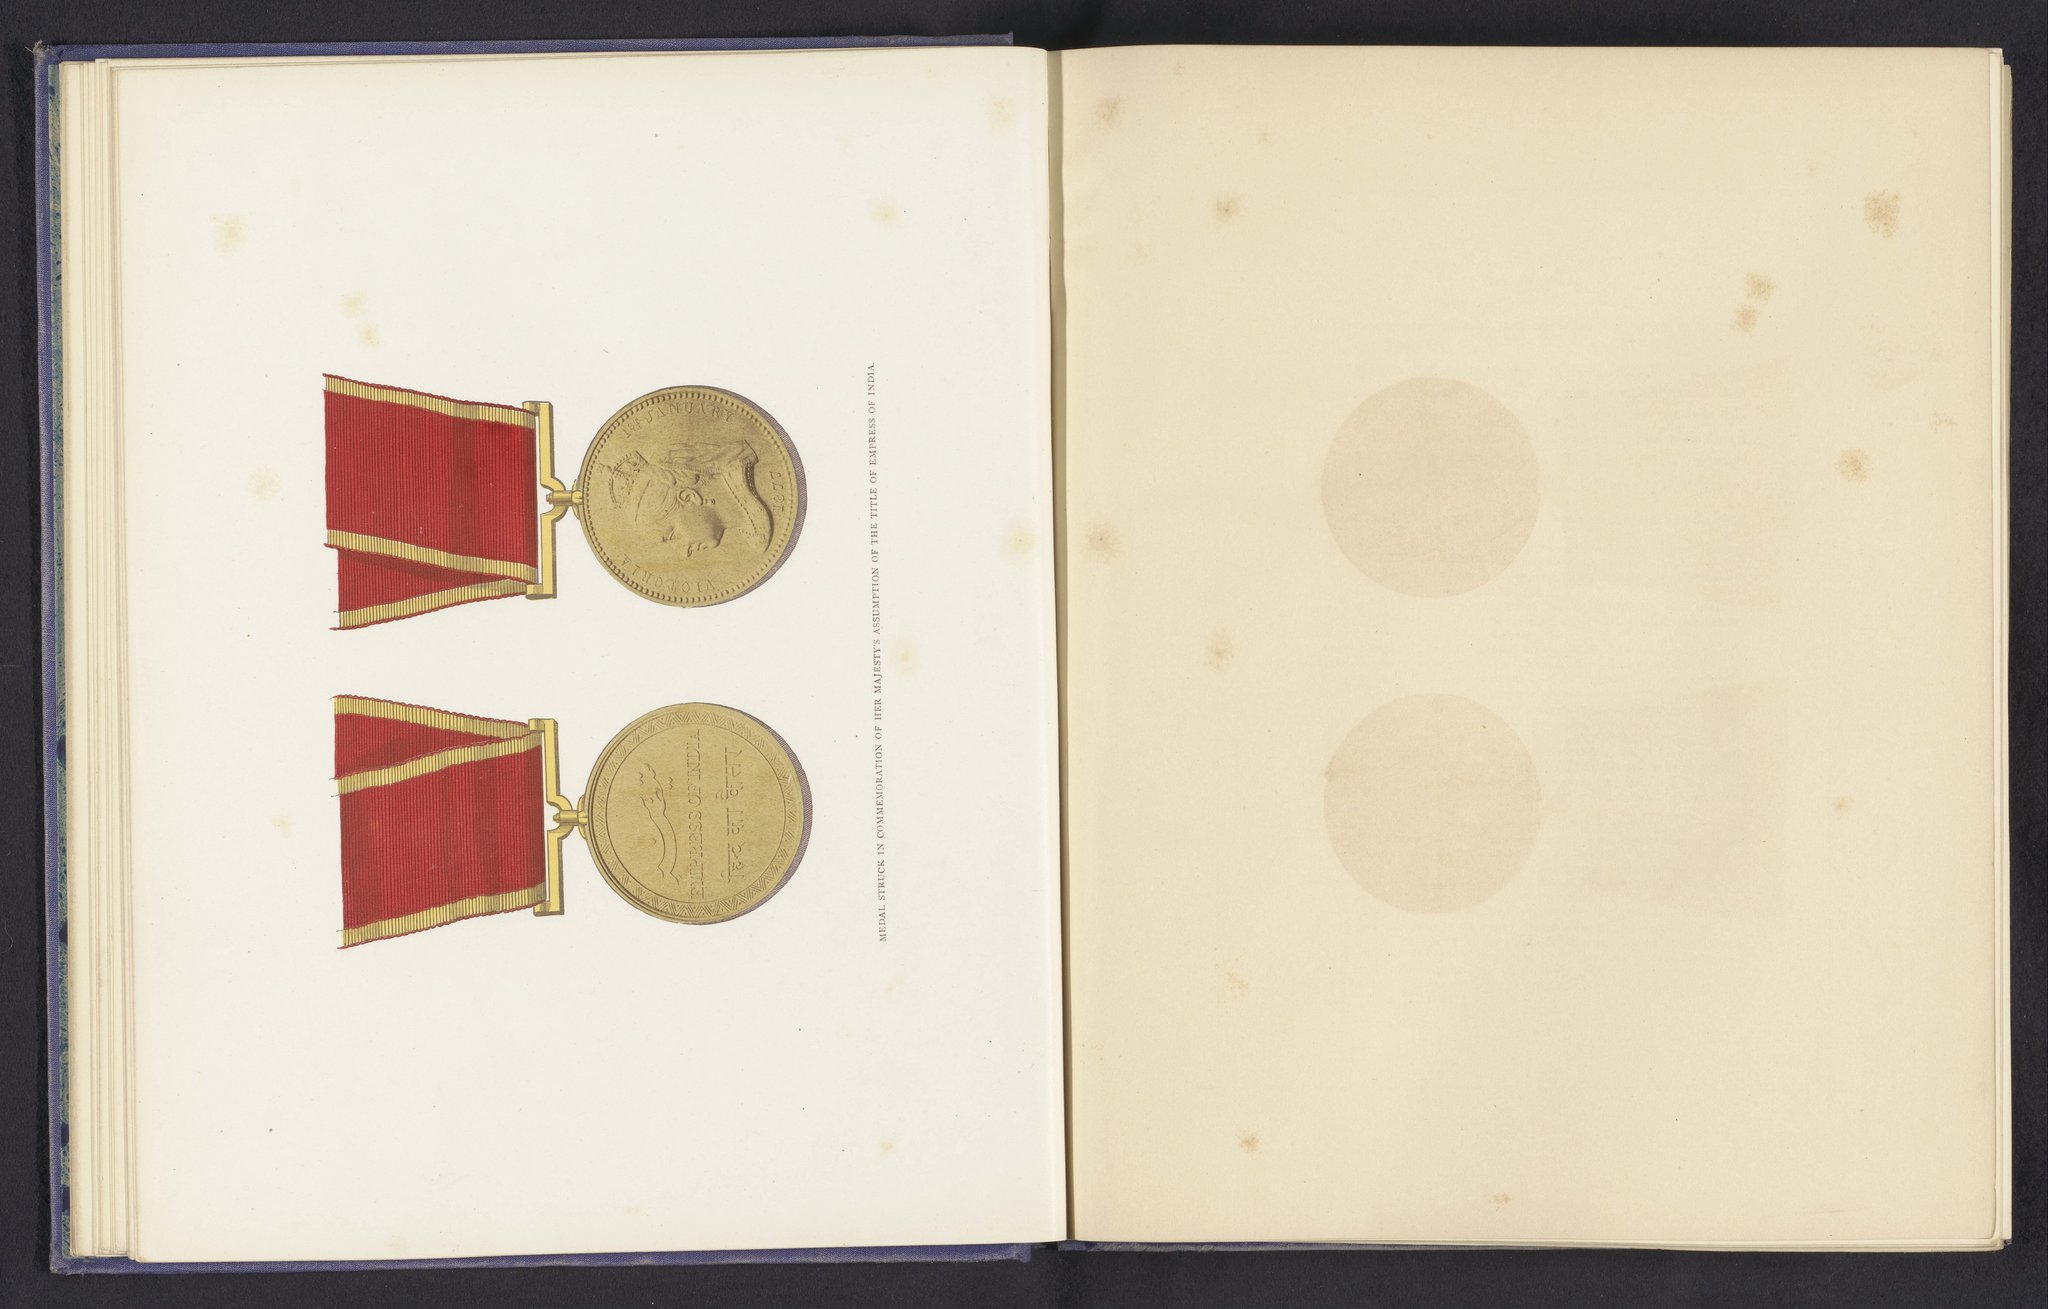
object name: photograph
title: Medal struck in commemoration of her Majesty's assumption of the title of Empress on India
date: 1876-1877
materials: photographic support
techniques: albumen print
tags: victoria (koningin van het verenigd koninkrijk en keizerin van india), ruler, sovereign - bb - female ruler